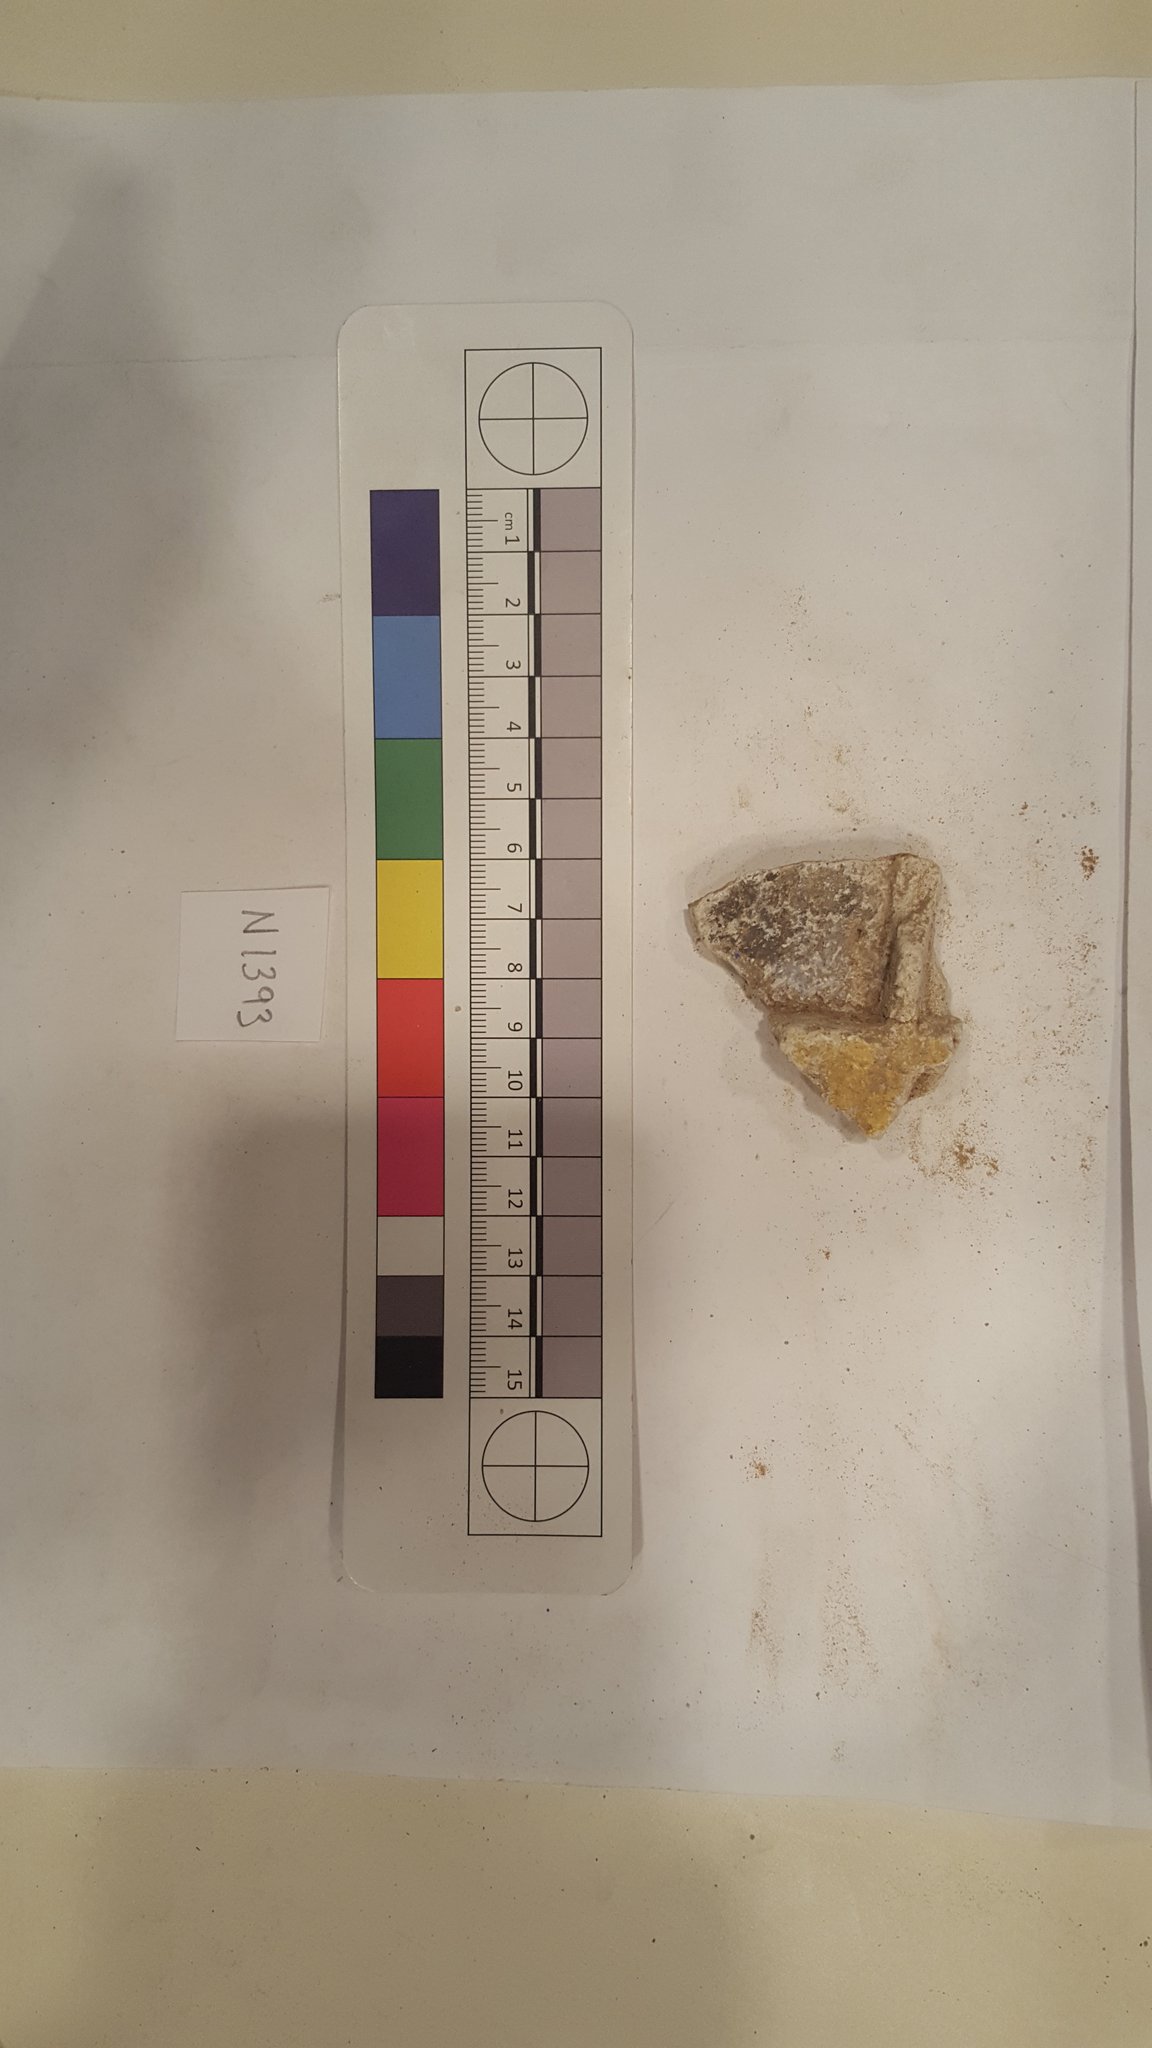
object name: fragment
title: Stucco Fragment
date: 701-1200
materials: plaster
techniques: carving, painting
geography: iran